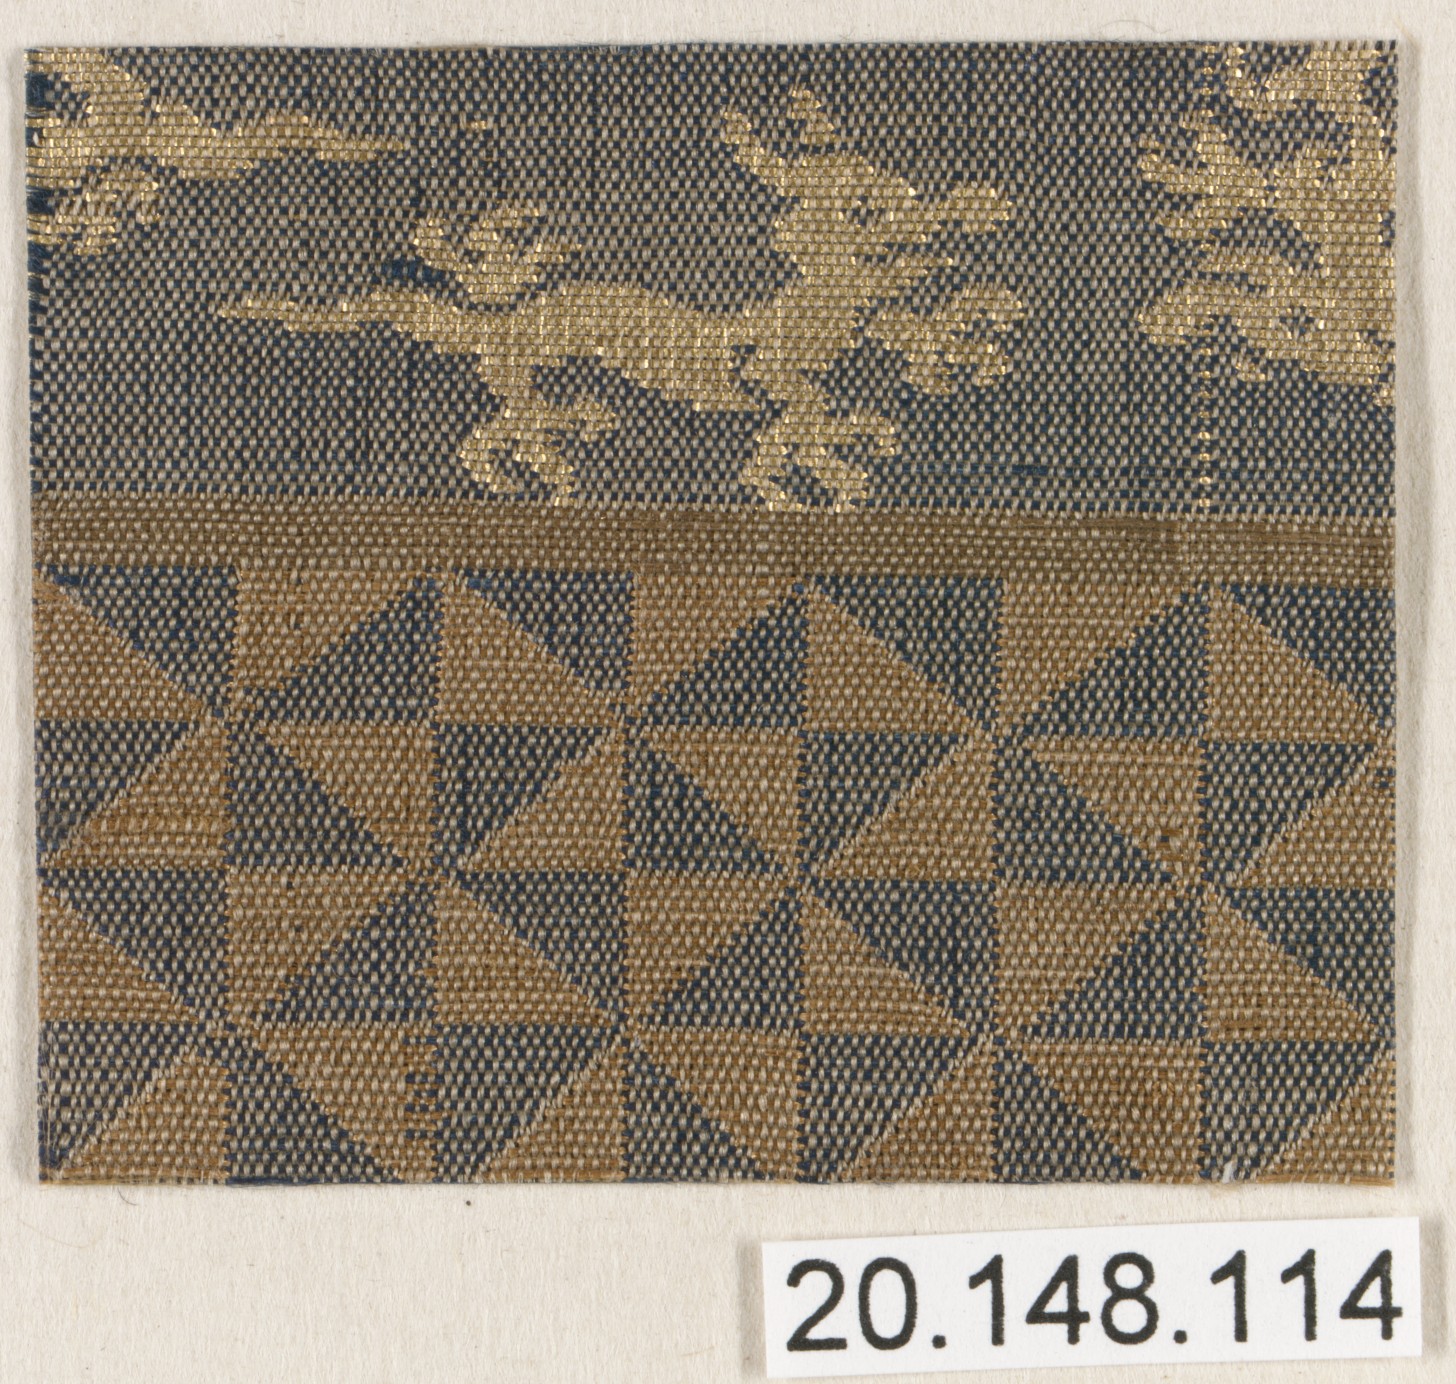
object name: piece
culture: japanese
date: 1701-1800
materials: silk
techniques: compound weave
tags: animals